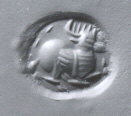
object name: stamp seal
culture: sasanian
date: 401-700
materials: stone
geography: iran